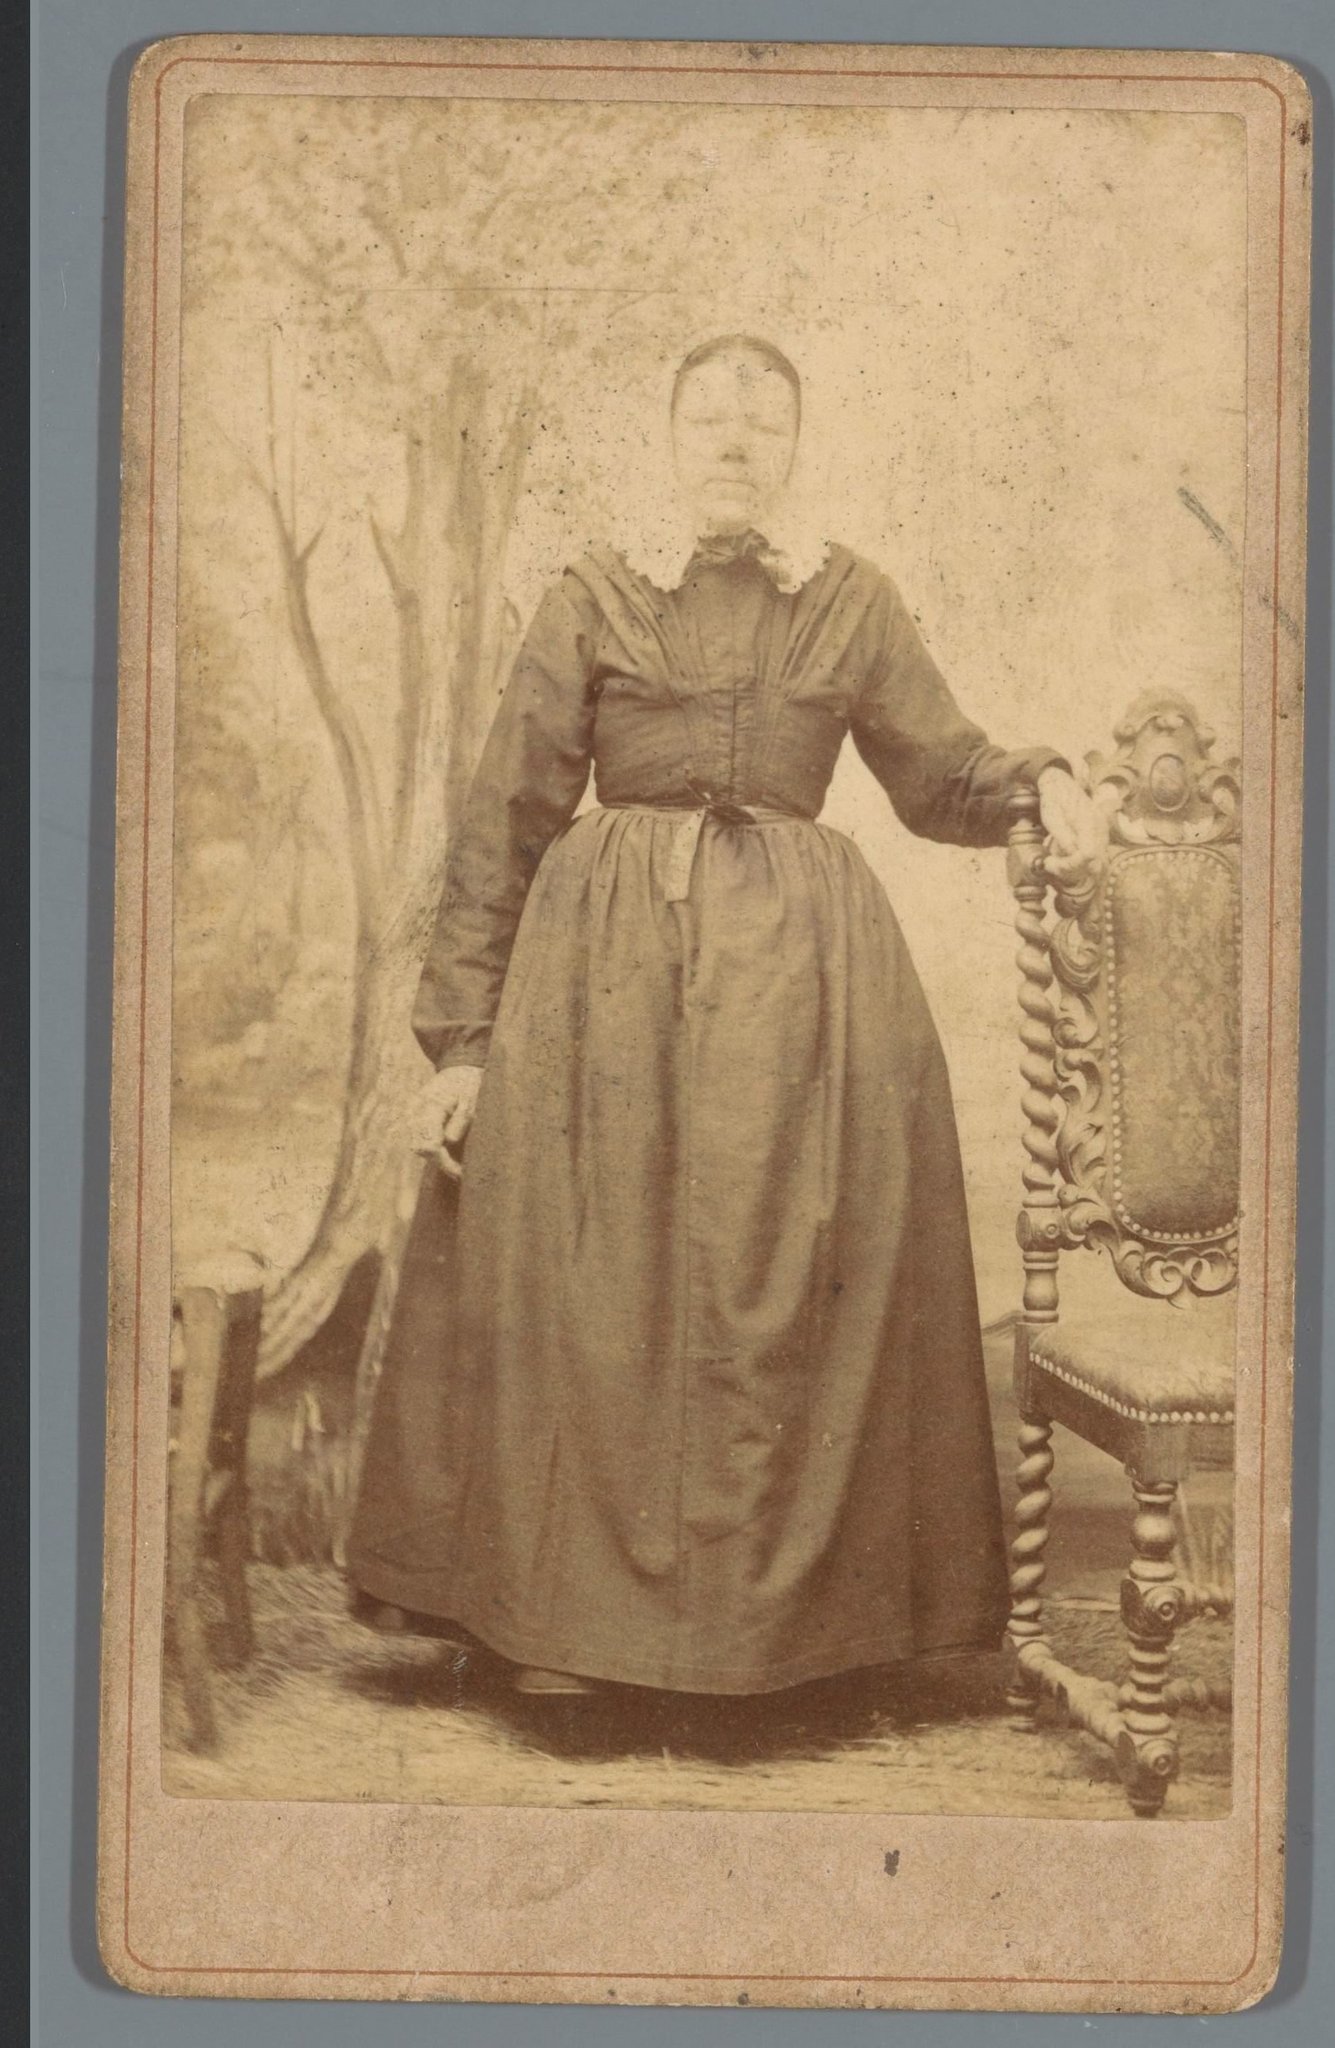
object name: photograph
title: Portret van een onbekende vrouw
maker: jan siewers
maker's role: fotograaf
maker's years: 1848-1918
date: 1890-1918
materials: cardboard, paper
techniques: albumen print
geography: hilversum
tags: historical persons - bb - woman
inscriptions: stamp: ‘J. SIEWERS,/ PHOTOGRAPHE./ HILVERSUM.’